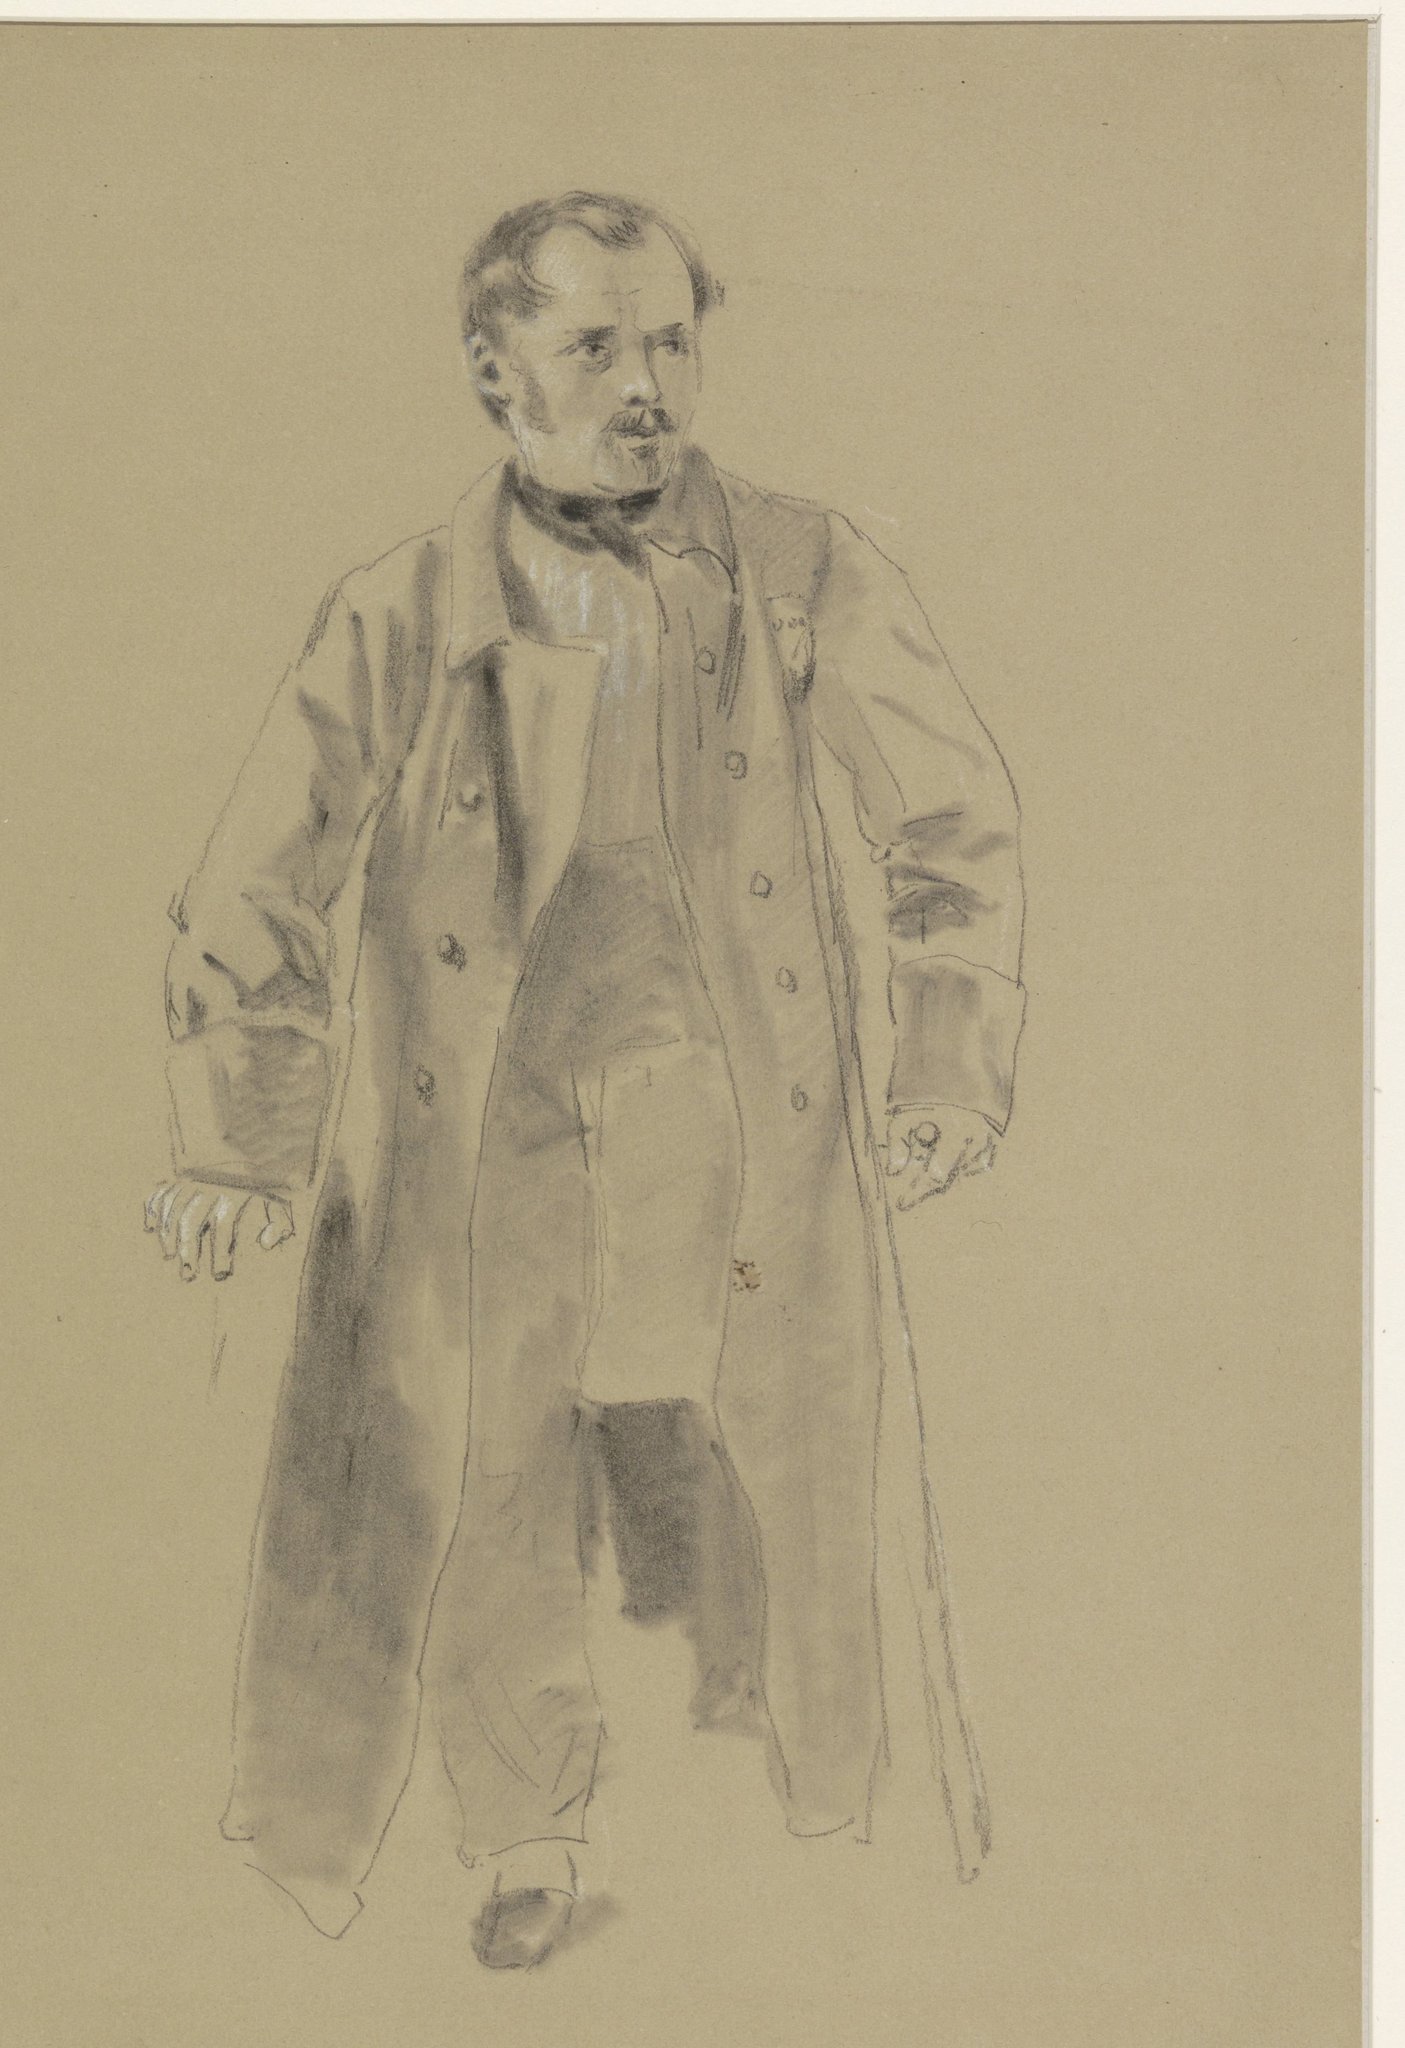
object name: drawing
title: Gewonde soldaat met kruk onder linkerarm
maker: jacob joseph eeckhout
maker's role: draughtsman, print maker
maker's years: 1793-1861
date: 1803-1861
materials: chalk, paper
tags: crutches, disabled soldier